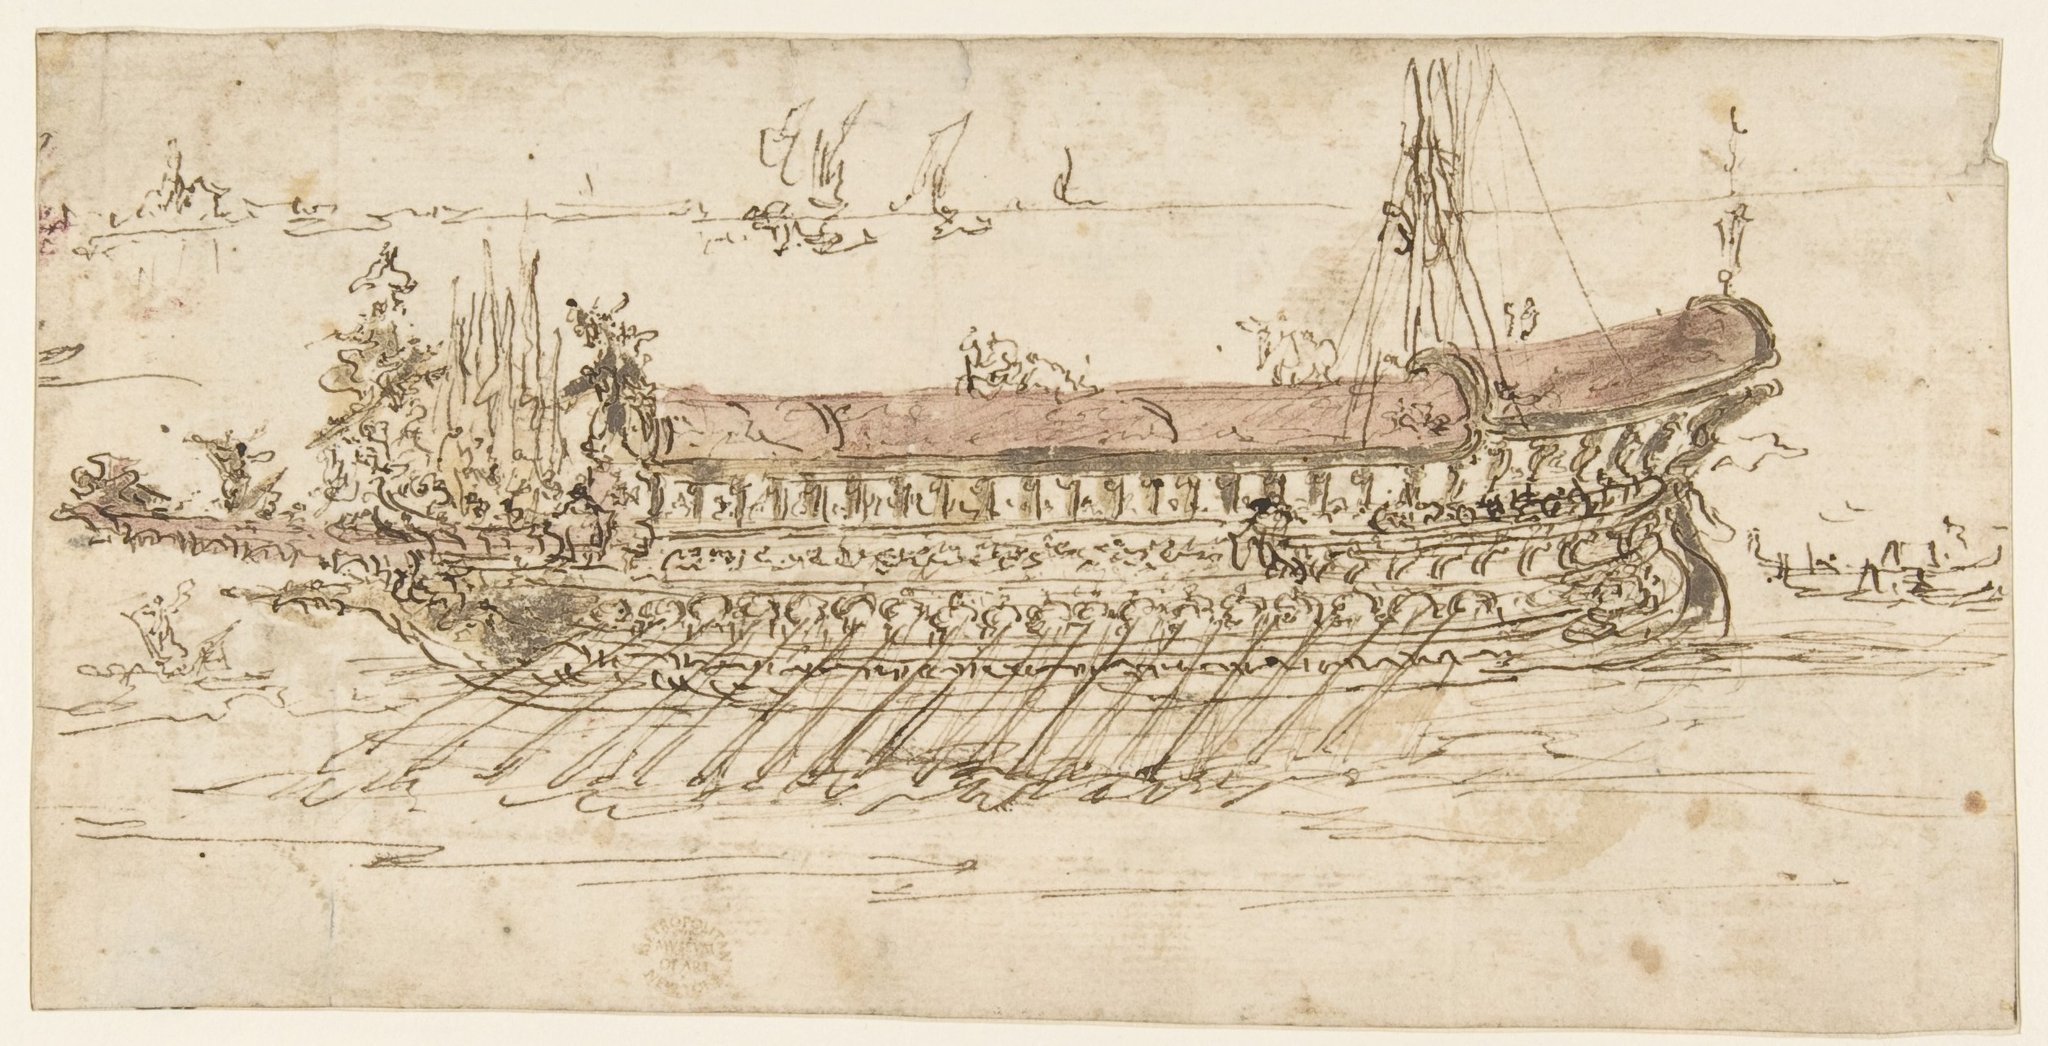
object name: drawing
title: The Bucintoro Moving to the Left (recto); The Bucintoro Moving to the Right (verso)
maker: francesco guardi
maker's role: artist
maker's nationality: italian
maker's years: 1712-1793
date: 1712-1793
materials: ink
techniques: brush, pen, wash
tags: ships